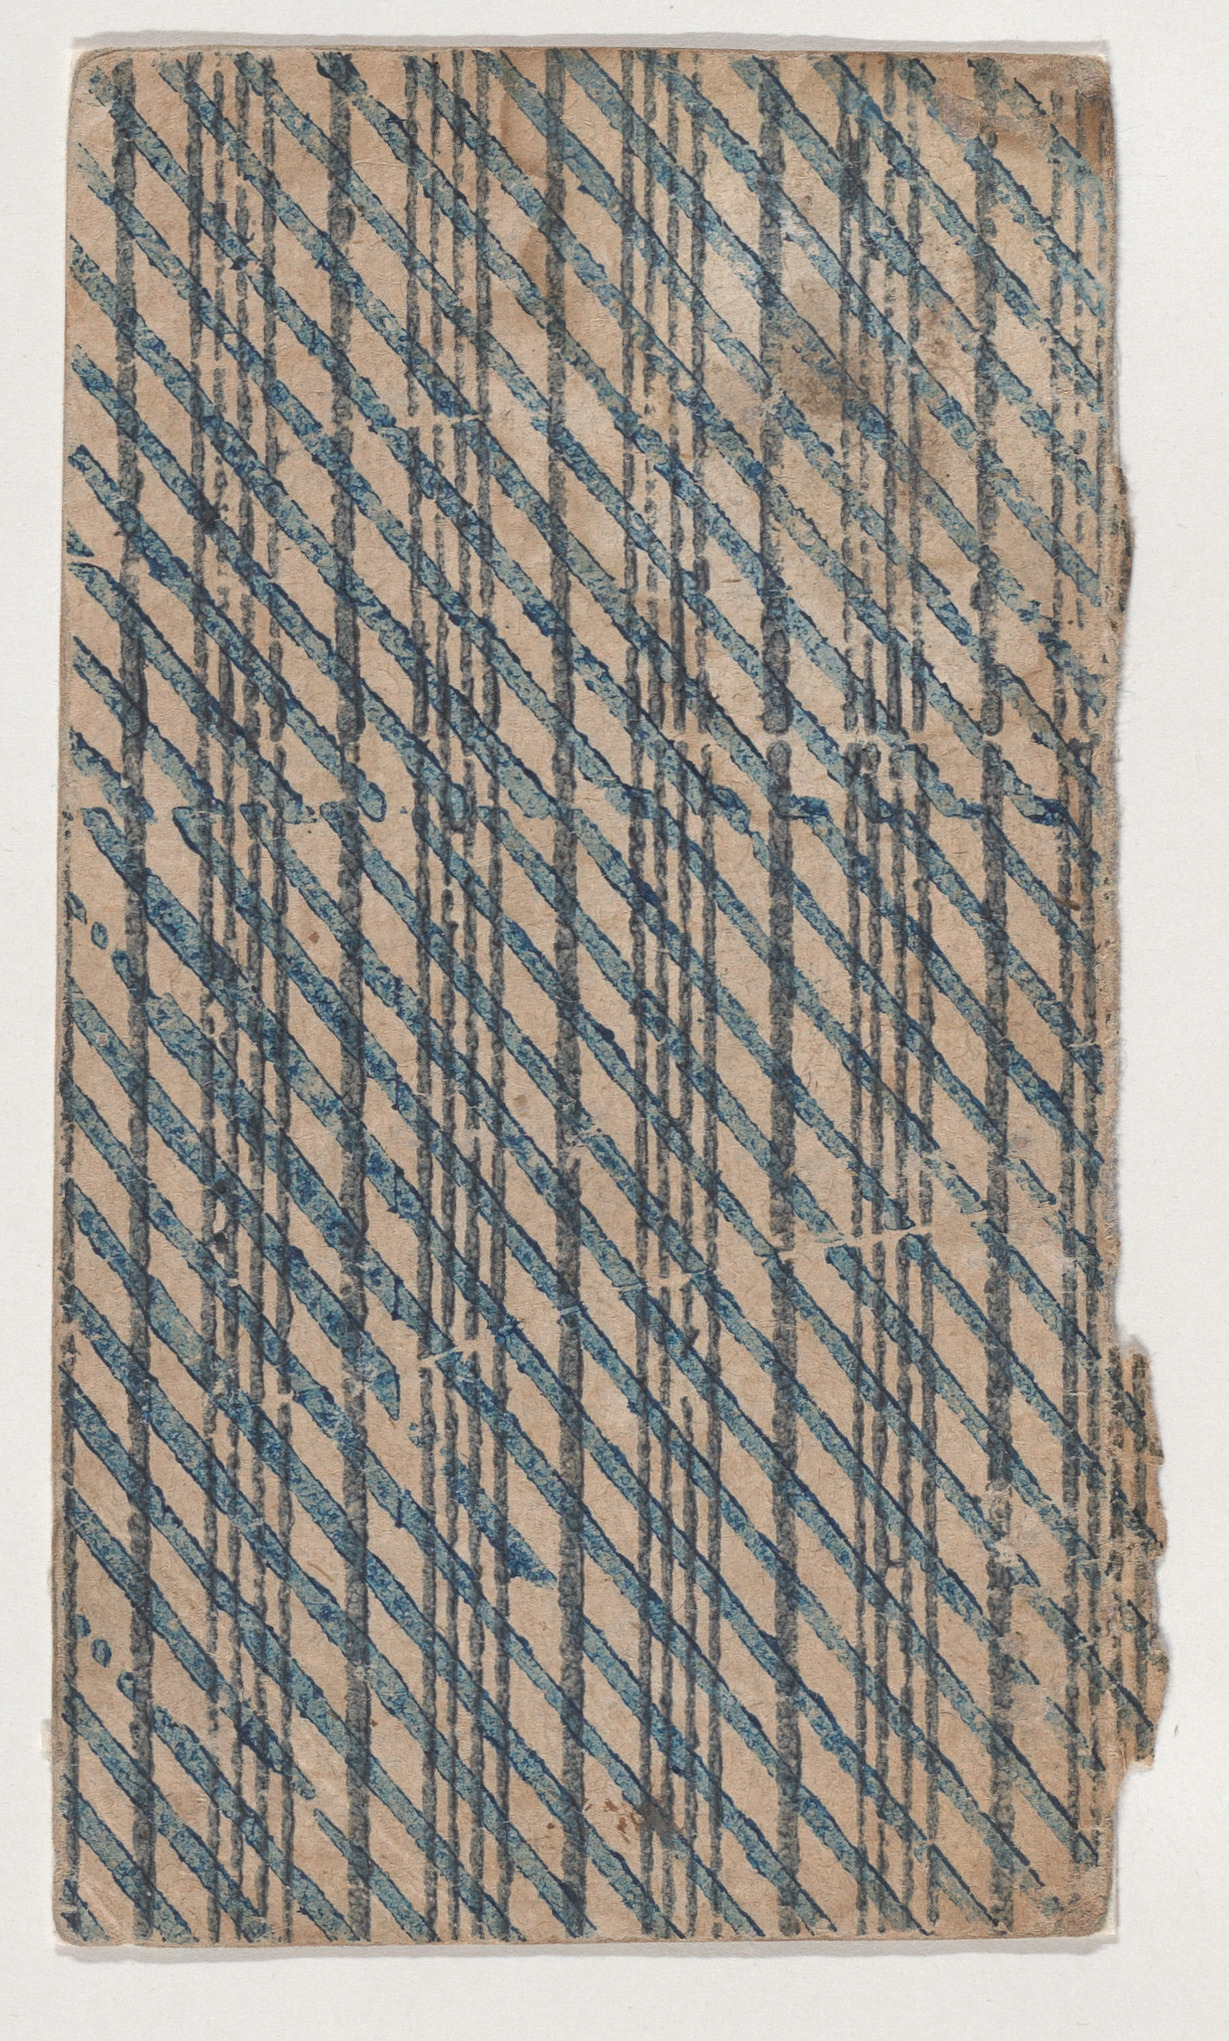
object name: print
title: Sheet with horizontal and diagonal stripe pattern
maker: Anonymous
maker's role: artist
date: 1801-1900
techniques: relief print